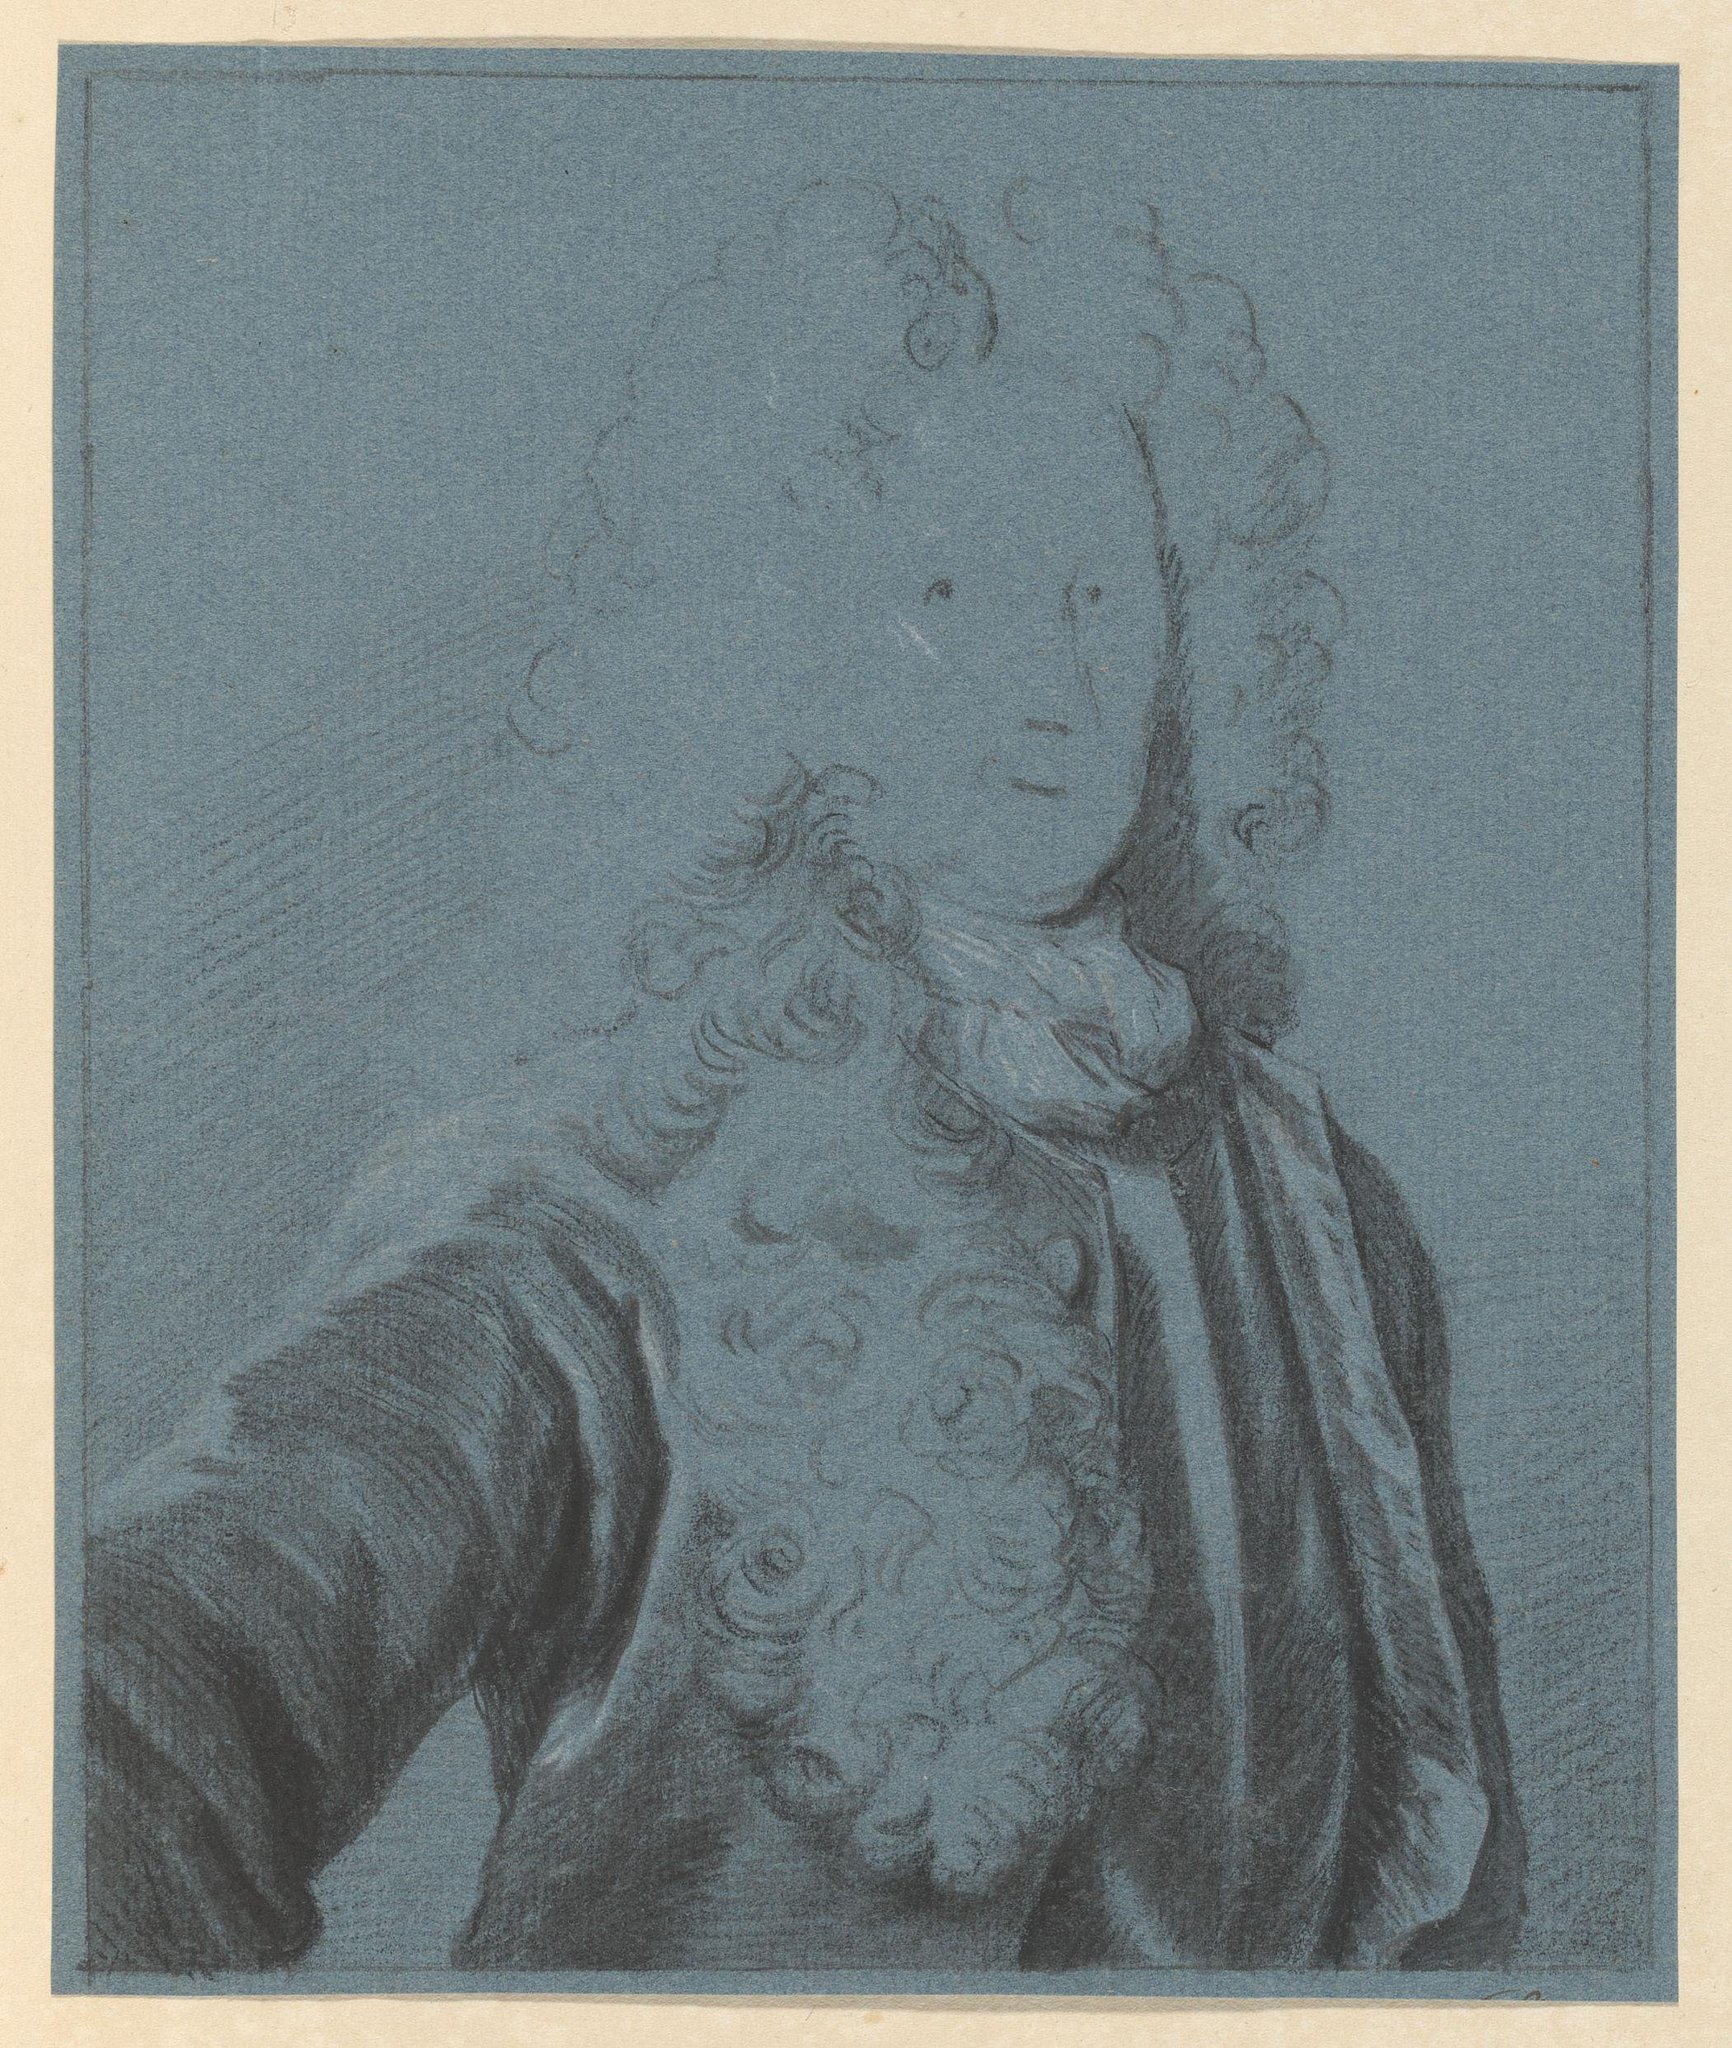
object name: drawing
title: Portret van een man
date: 1649-1723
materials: chalk, paper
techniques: pasting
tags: wig, historical persons not known by name